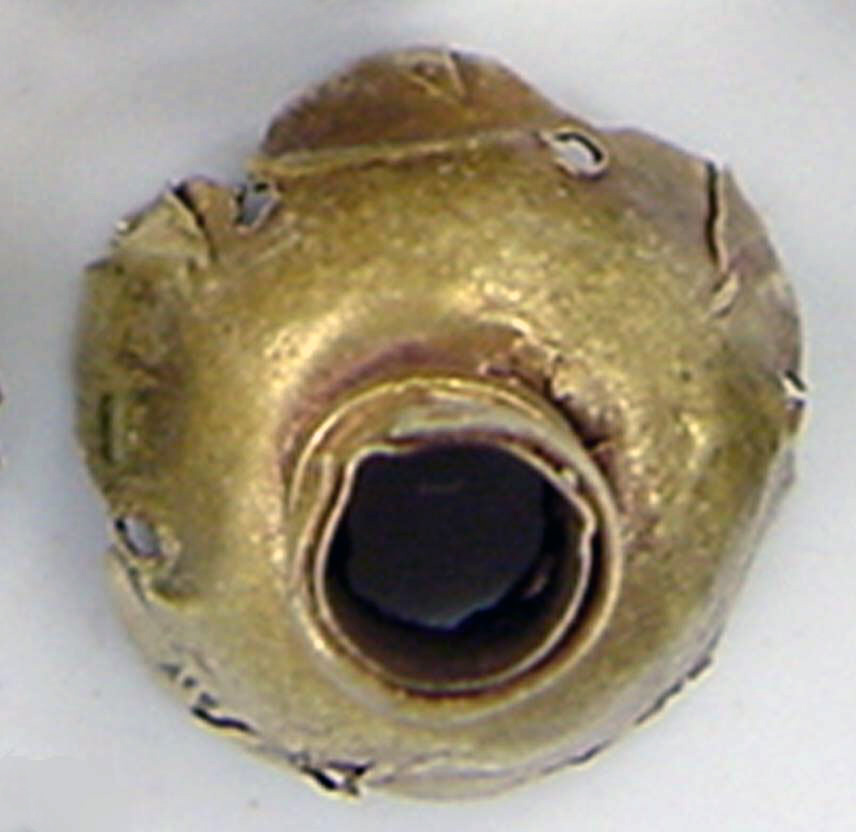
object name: plaque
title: Flower-Shaped Plaque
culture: northwest chinese or eastern central asian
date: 634-900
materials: gold